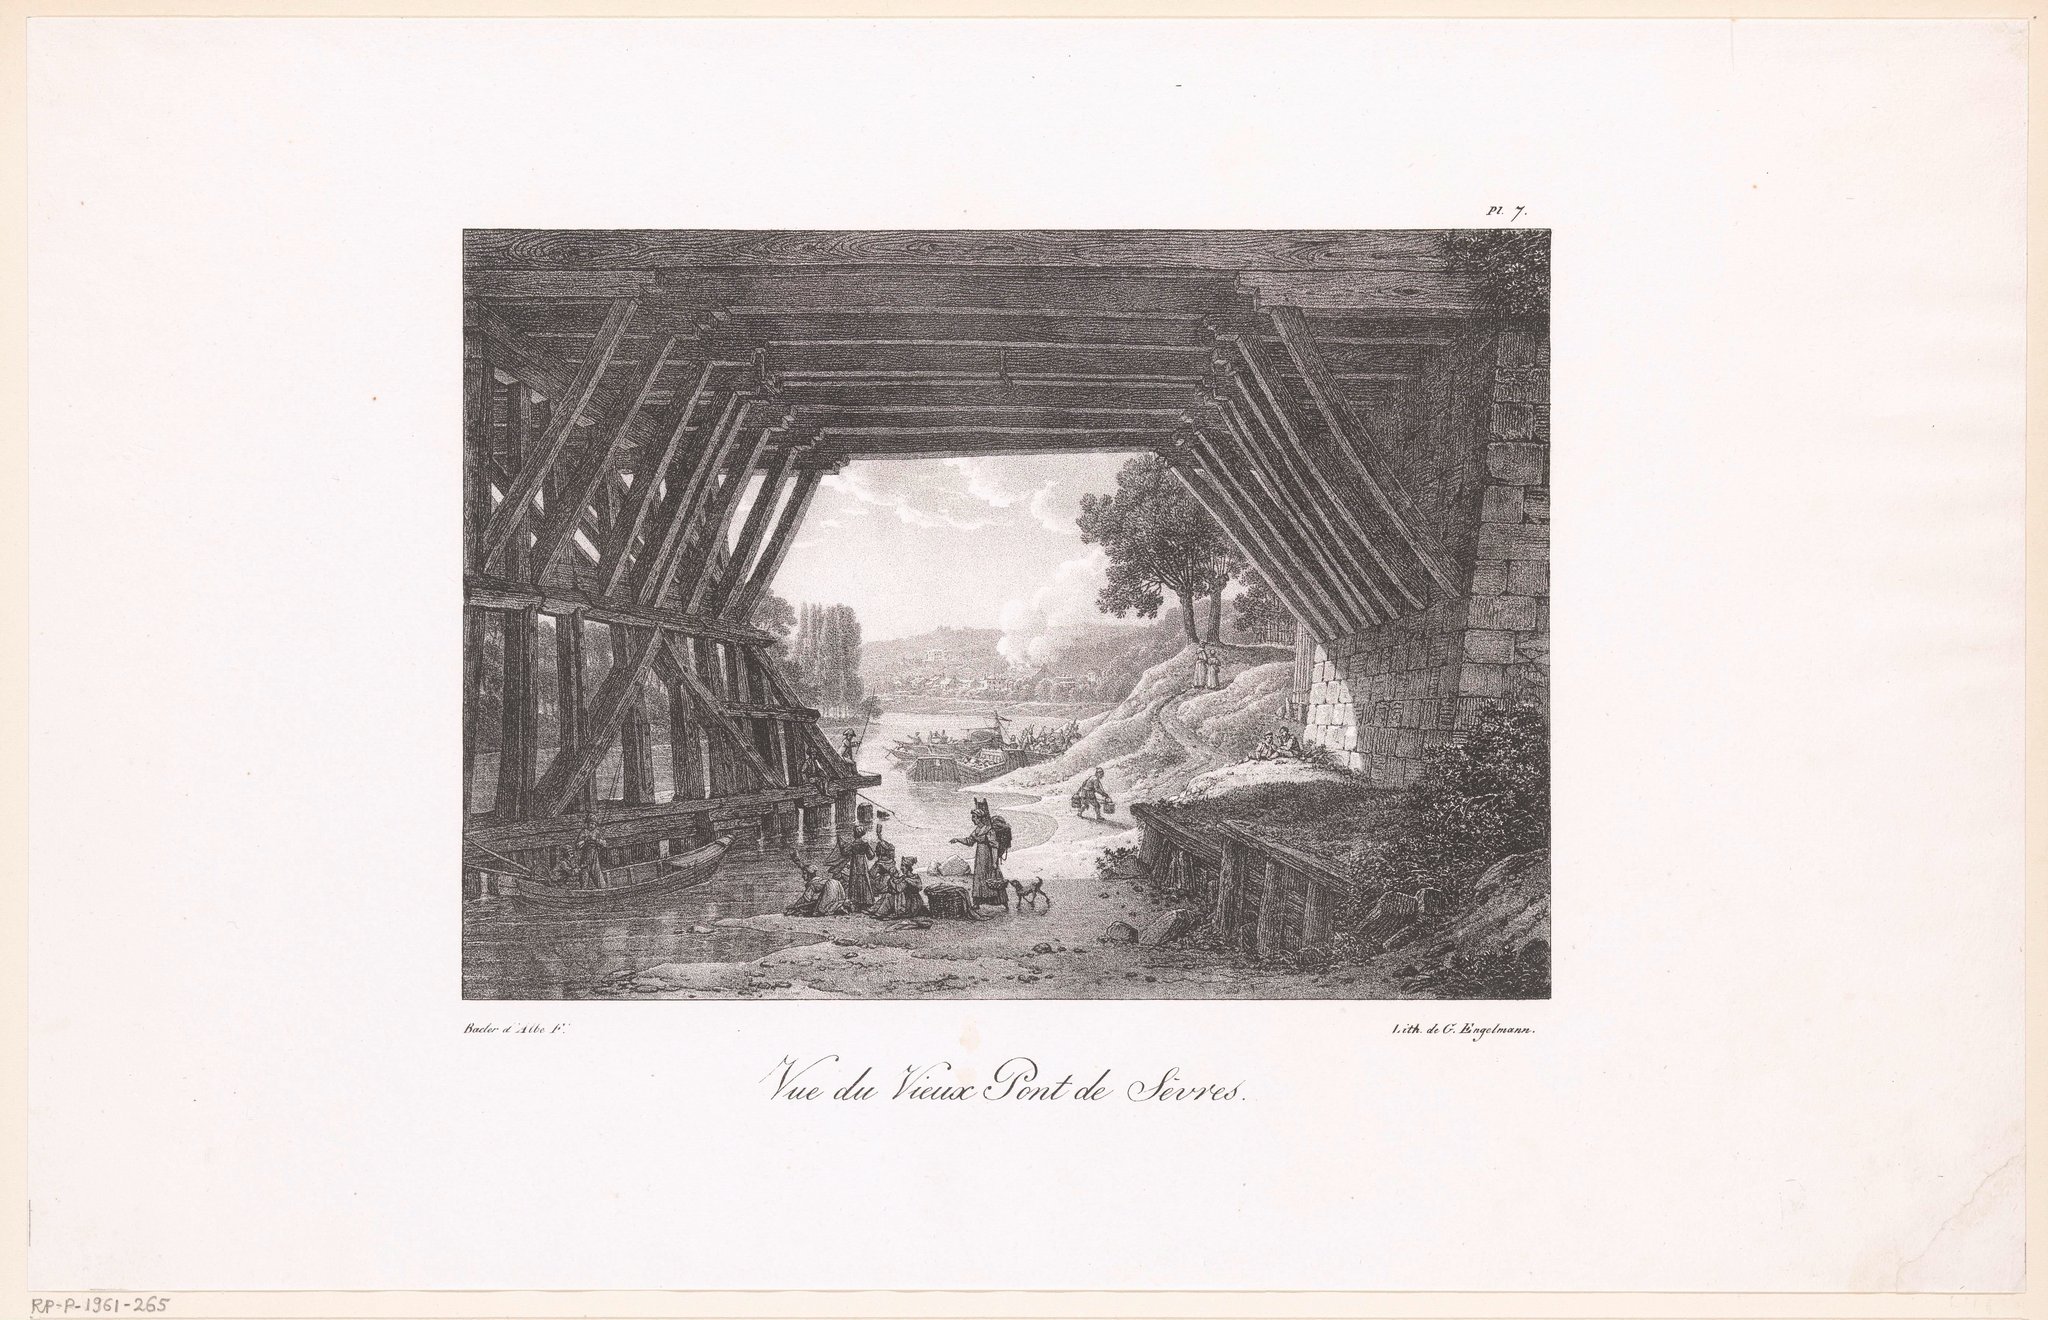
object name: print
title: Vue du Vieux Pont de Sèvres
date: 1822-1824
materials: paper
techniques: lithograph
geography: paris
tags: landscape with bridge, viaduct or aqueduct (+ city(-scape) with figures, staffage)